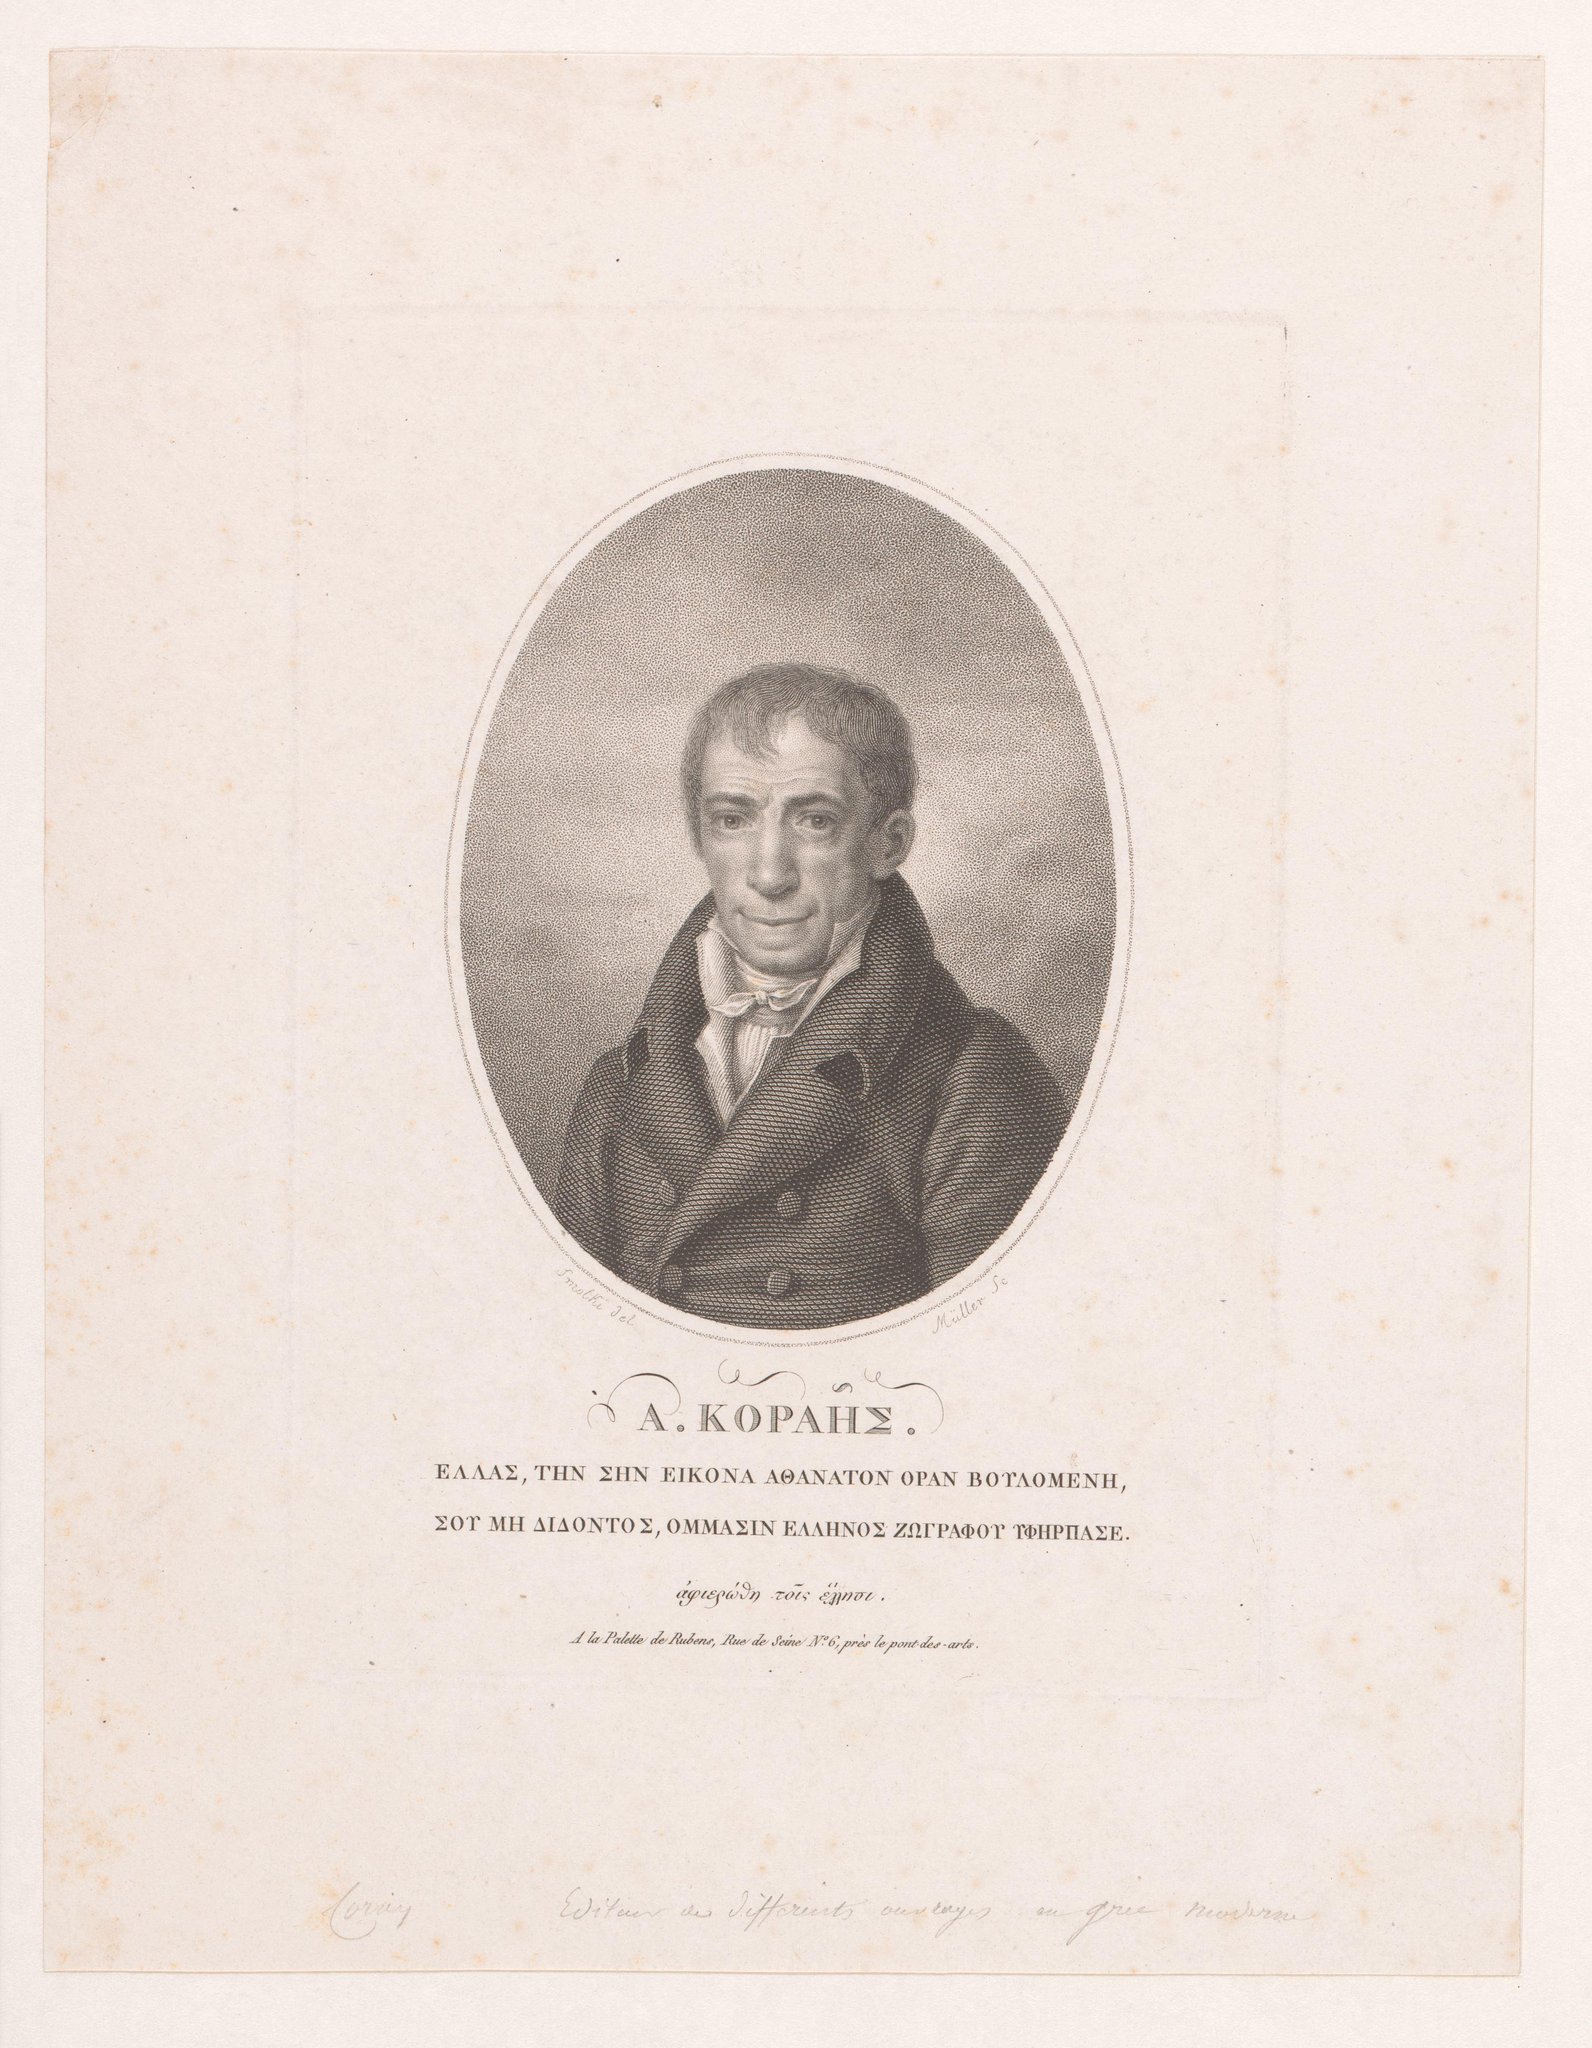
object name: print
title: Portret van Adamantios Korais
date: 1776-1824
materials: paper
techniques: etching, engraving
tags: paris, historical persons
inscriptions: collector's mark: Lugt 2228